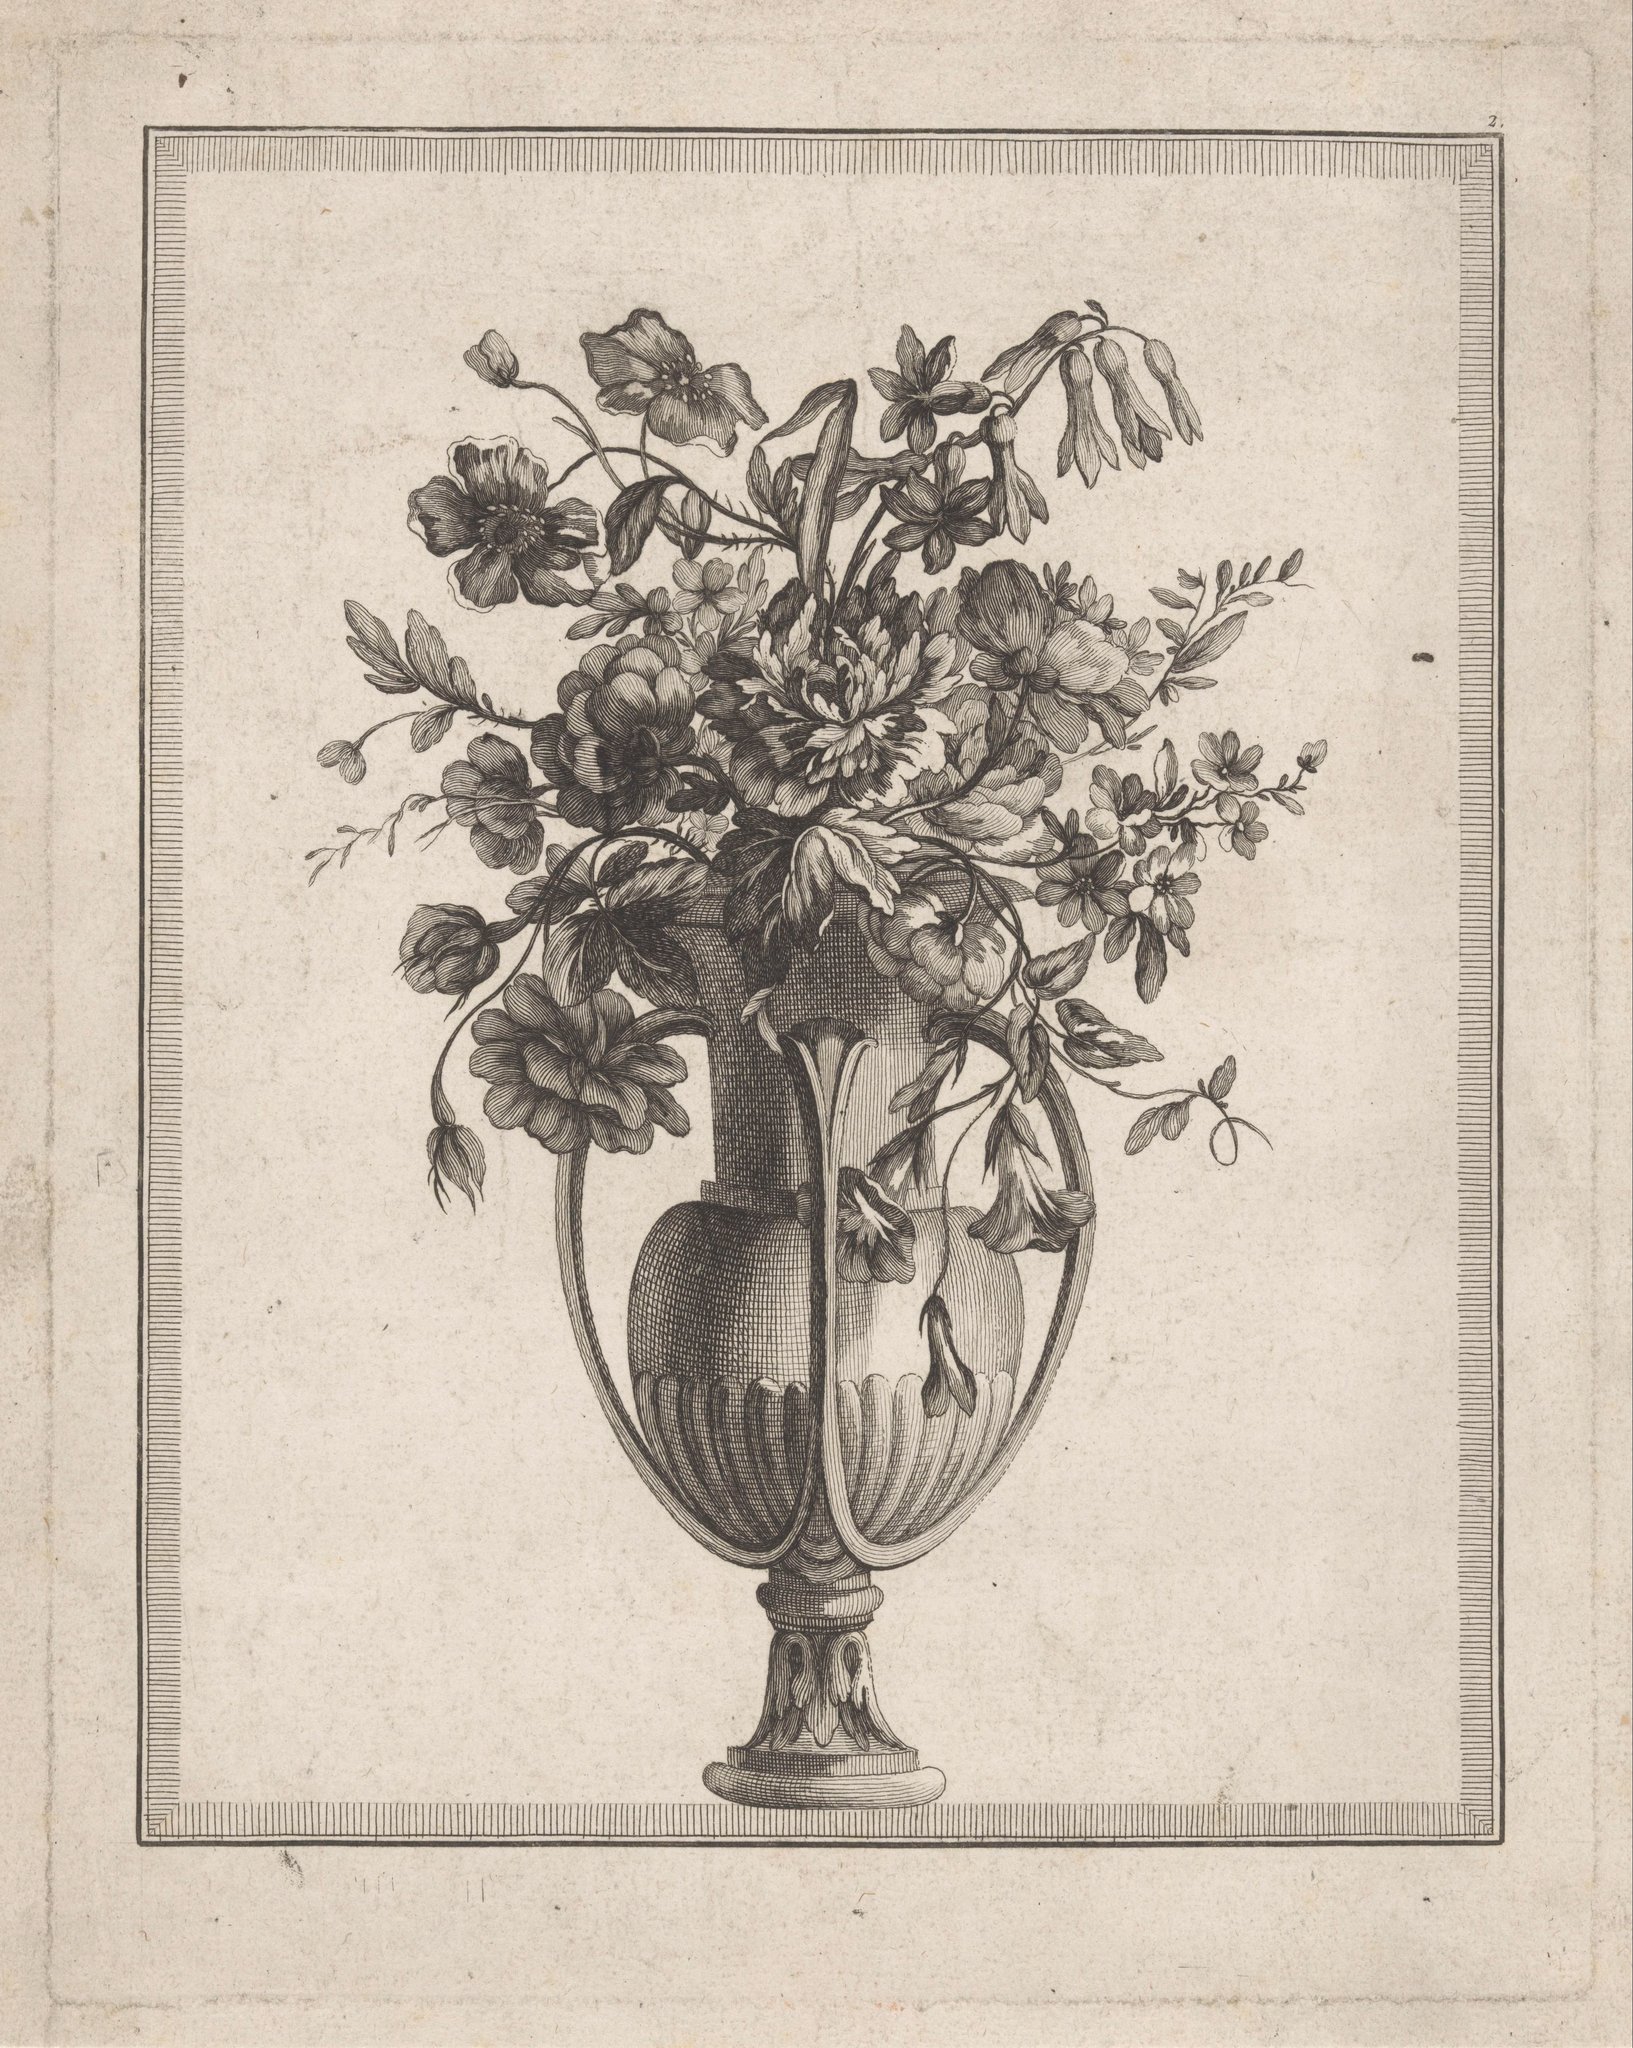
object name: print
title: Bloemen in vaas met drie oren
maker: etienne claude voysard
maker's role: print maker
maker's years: 1746-1812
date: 1778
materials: paper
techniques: etching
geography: paris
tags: flowers in a vase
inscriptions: collector's mark: Lugt 2228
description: Bloemen in een geornamenteerde vaas met drie oren.